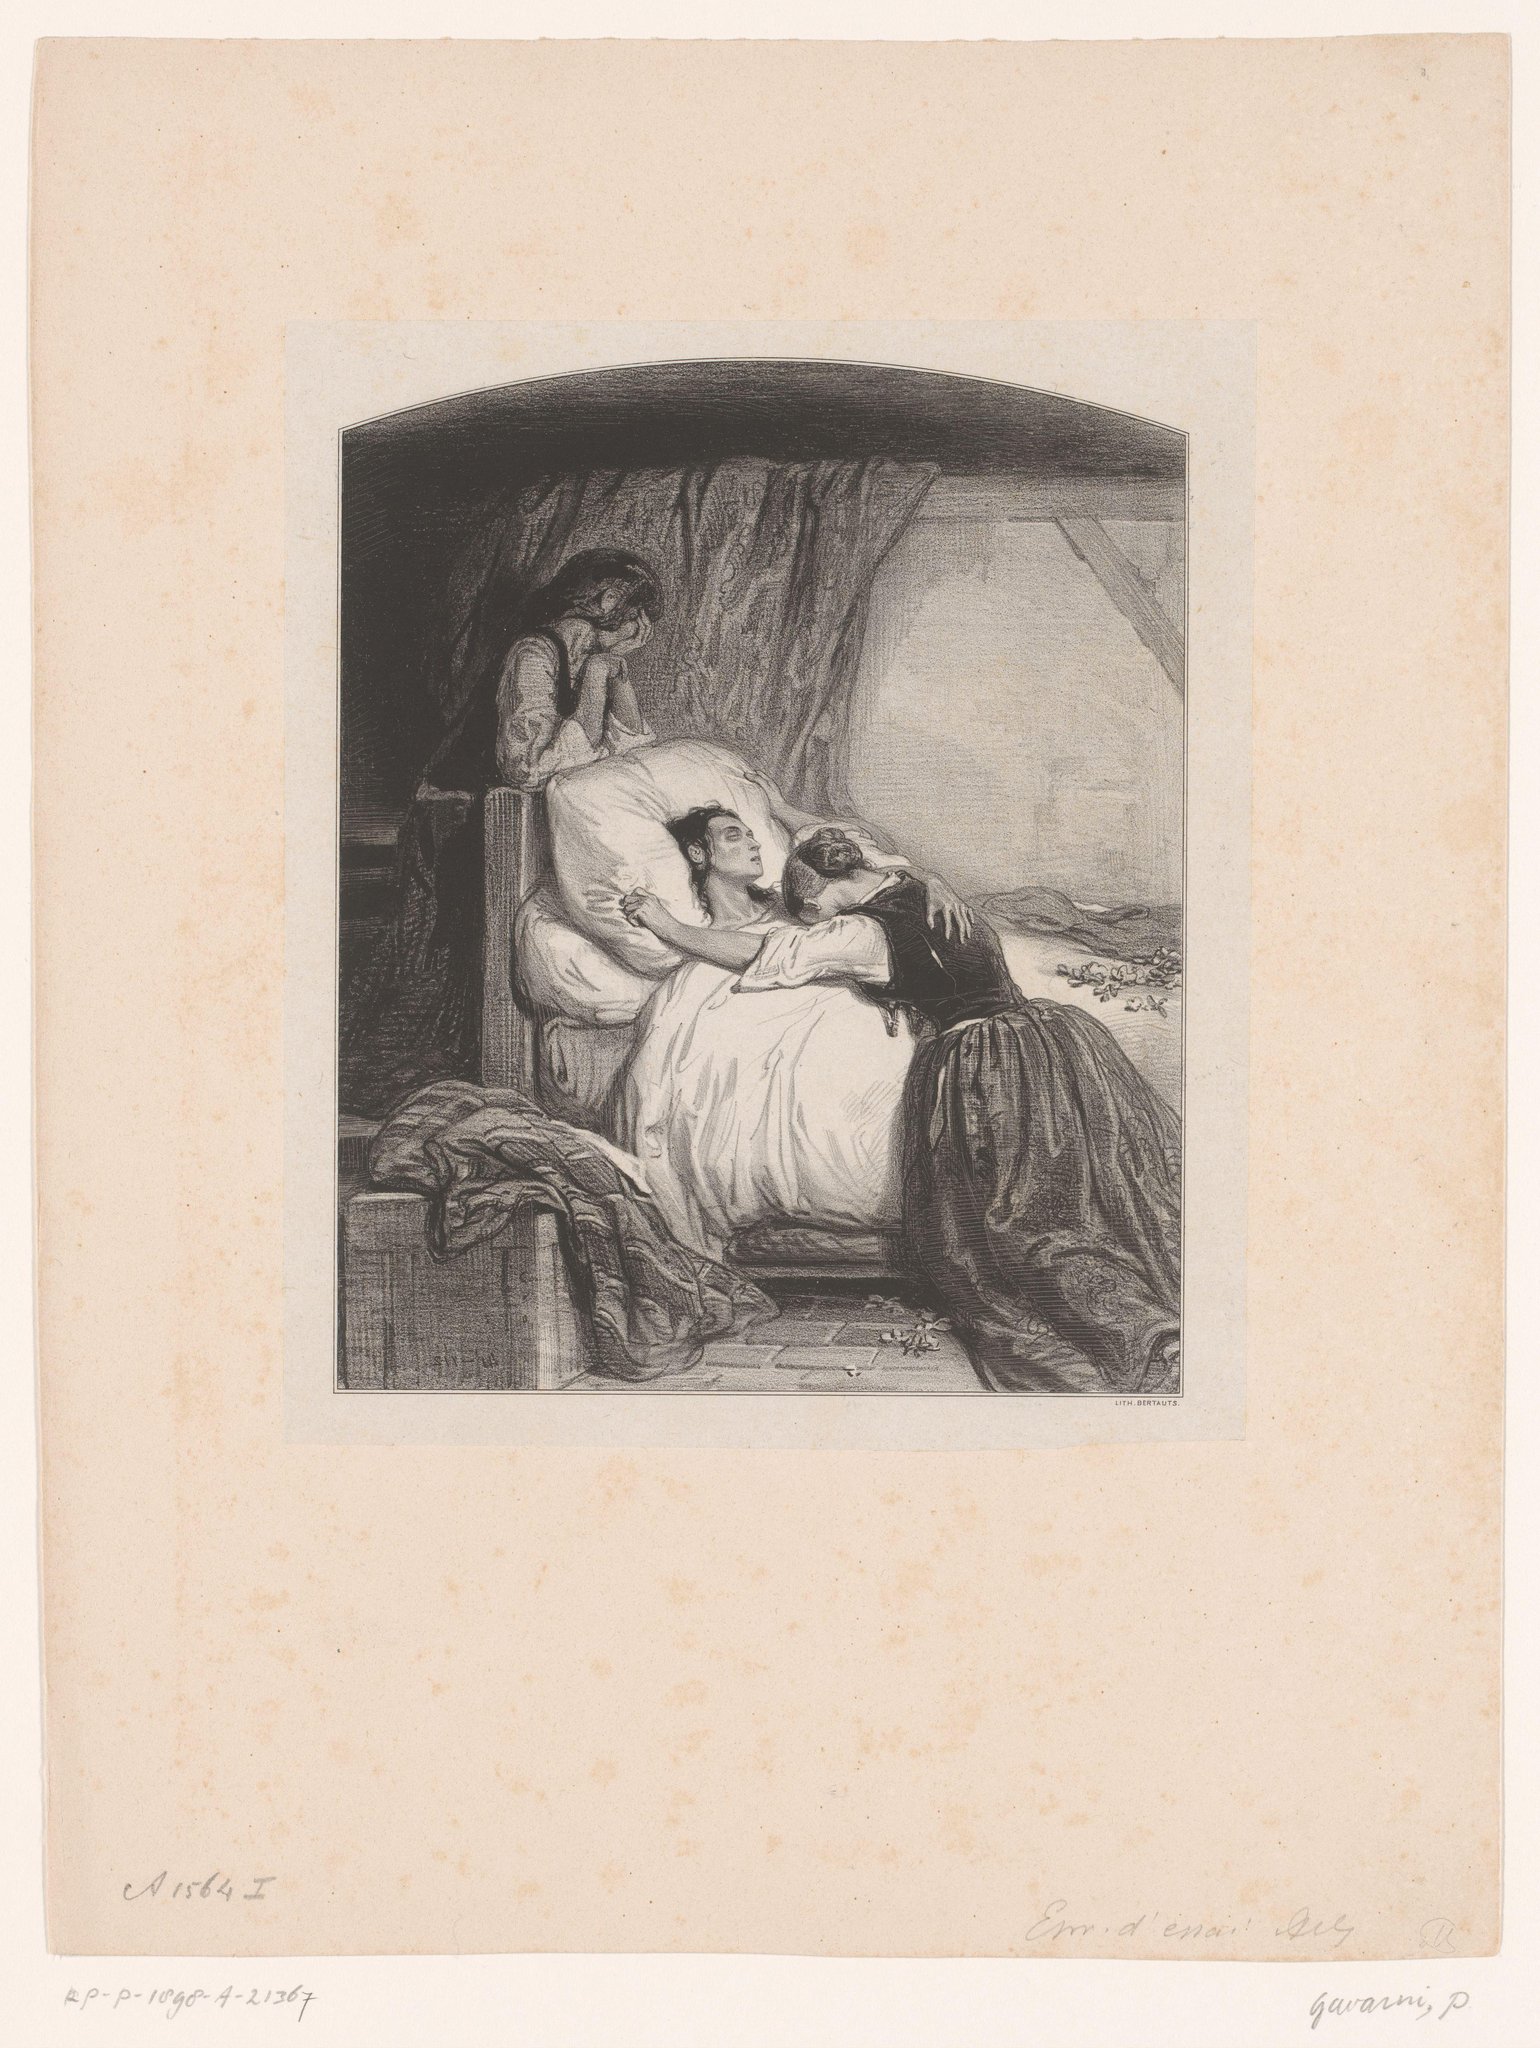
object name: print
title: Les chevaliers de la Belle-Étoile. Suzanne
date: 1843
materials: paper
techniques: lithograph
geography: paris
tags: deathbed, weeping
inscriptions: collector's mark: Lugt 964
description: Prent gebruikt voor: La Sylphide (Revue Parisienne), 4e serie, dl. 8, 1843.